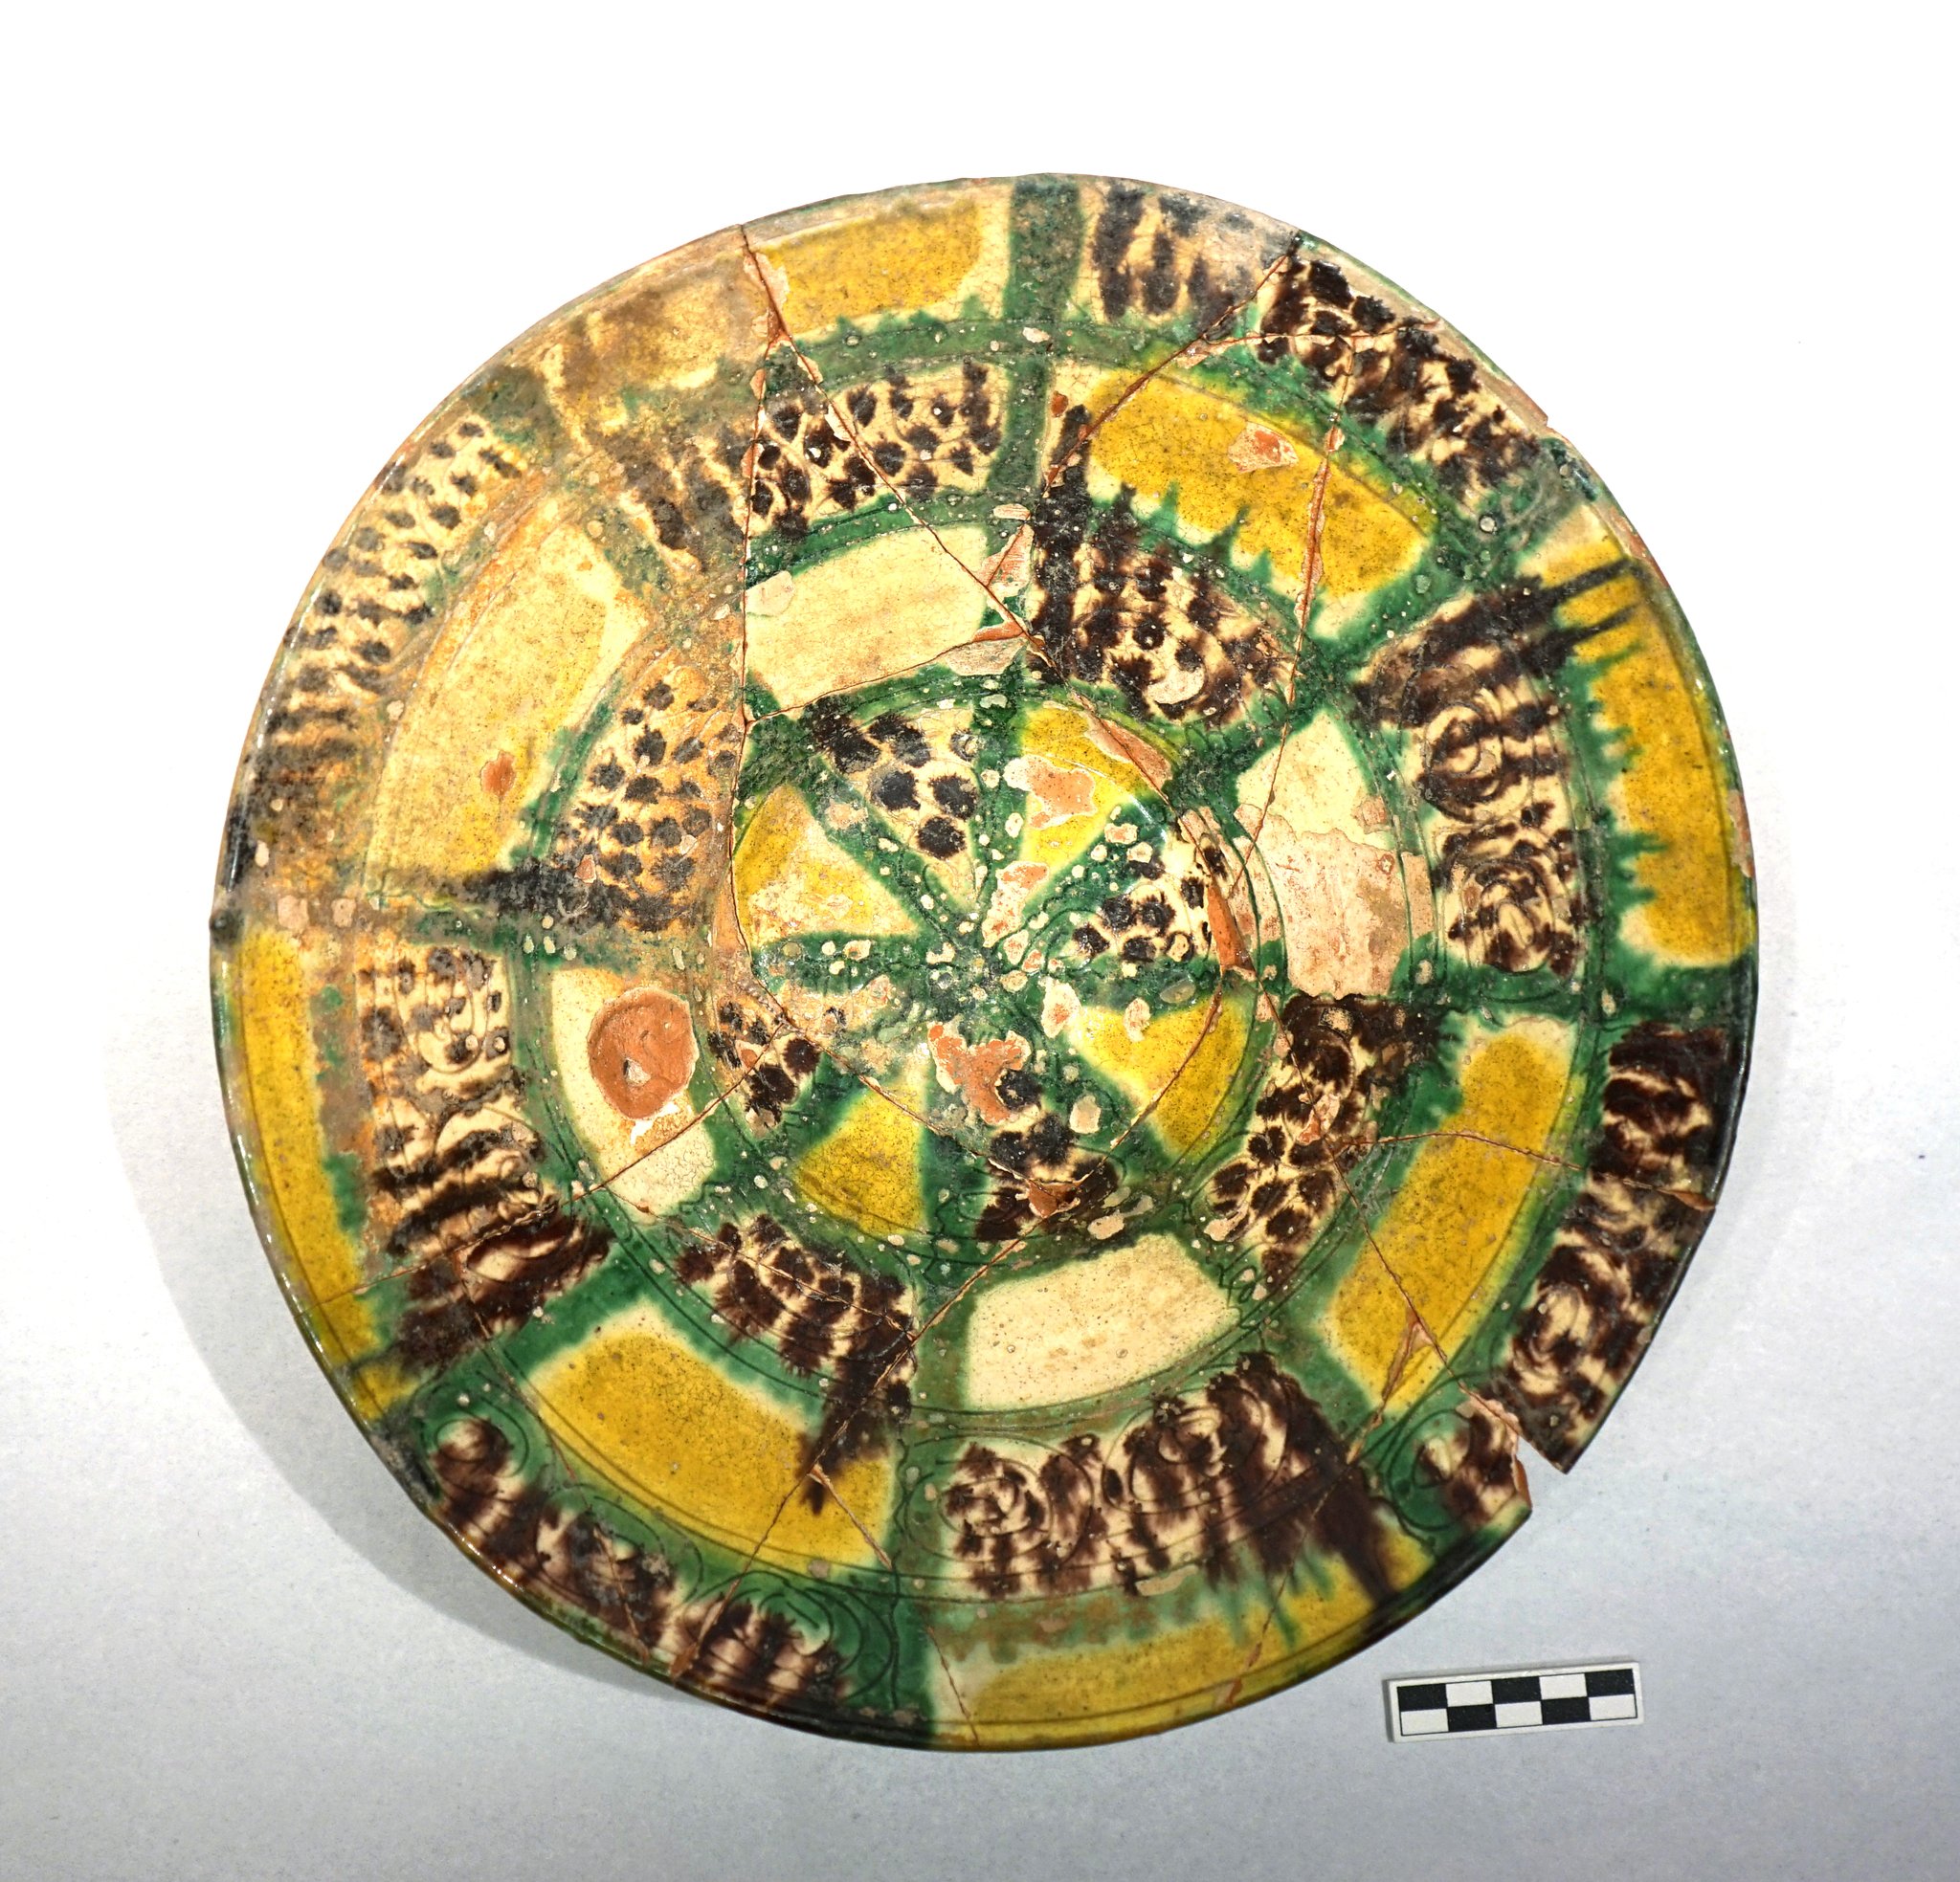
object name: bowl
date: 801-900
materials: earthenware, glaze, pigment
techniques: incising, painting, polychrome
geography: iran